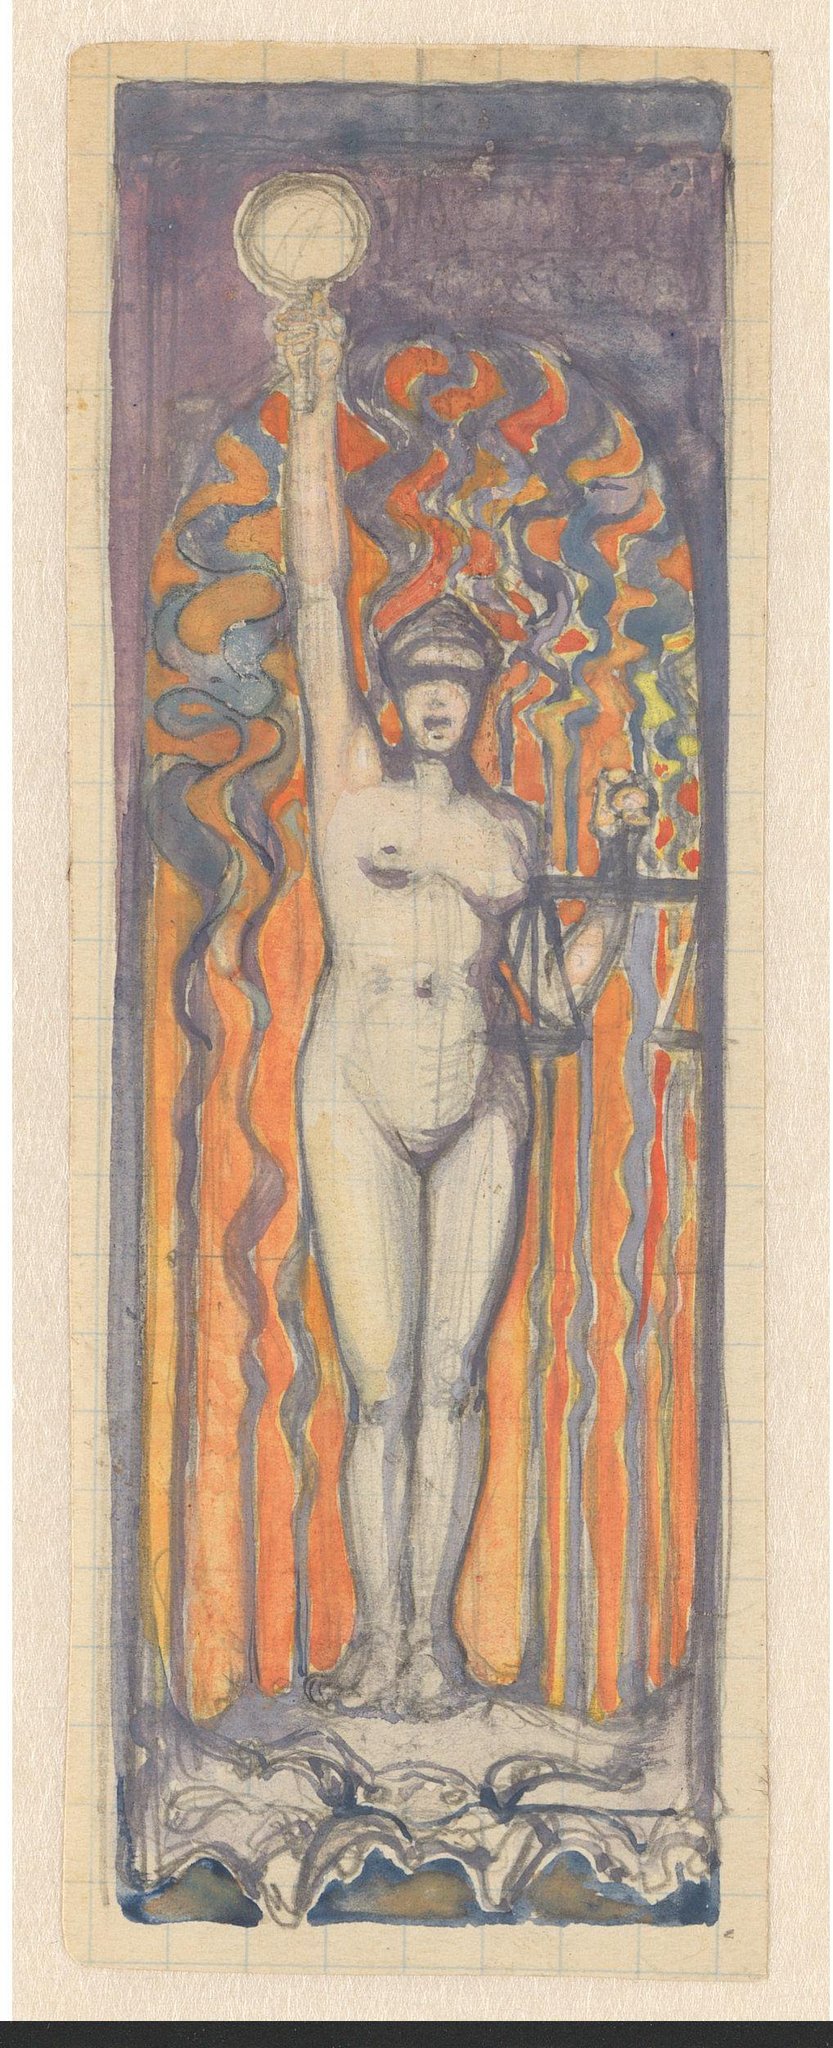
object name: drawing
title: Naakte vrouw met spiegel en een weegschaal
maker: bernard willem wierink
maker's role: draughtsman, print maker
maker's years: 1856-1939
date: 1915-1916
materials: paper, pencil, watercolor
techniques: brush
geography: amsterdam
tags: mirror